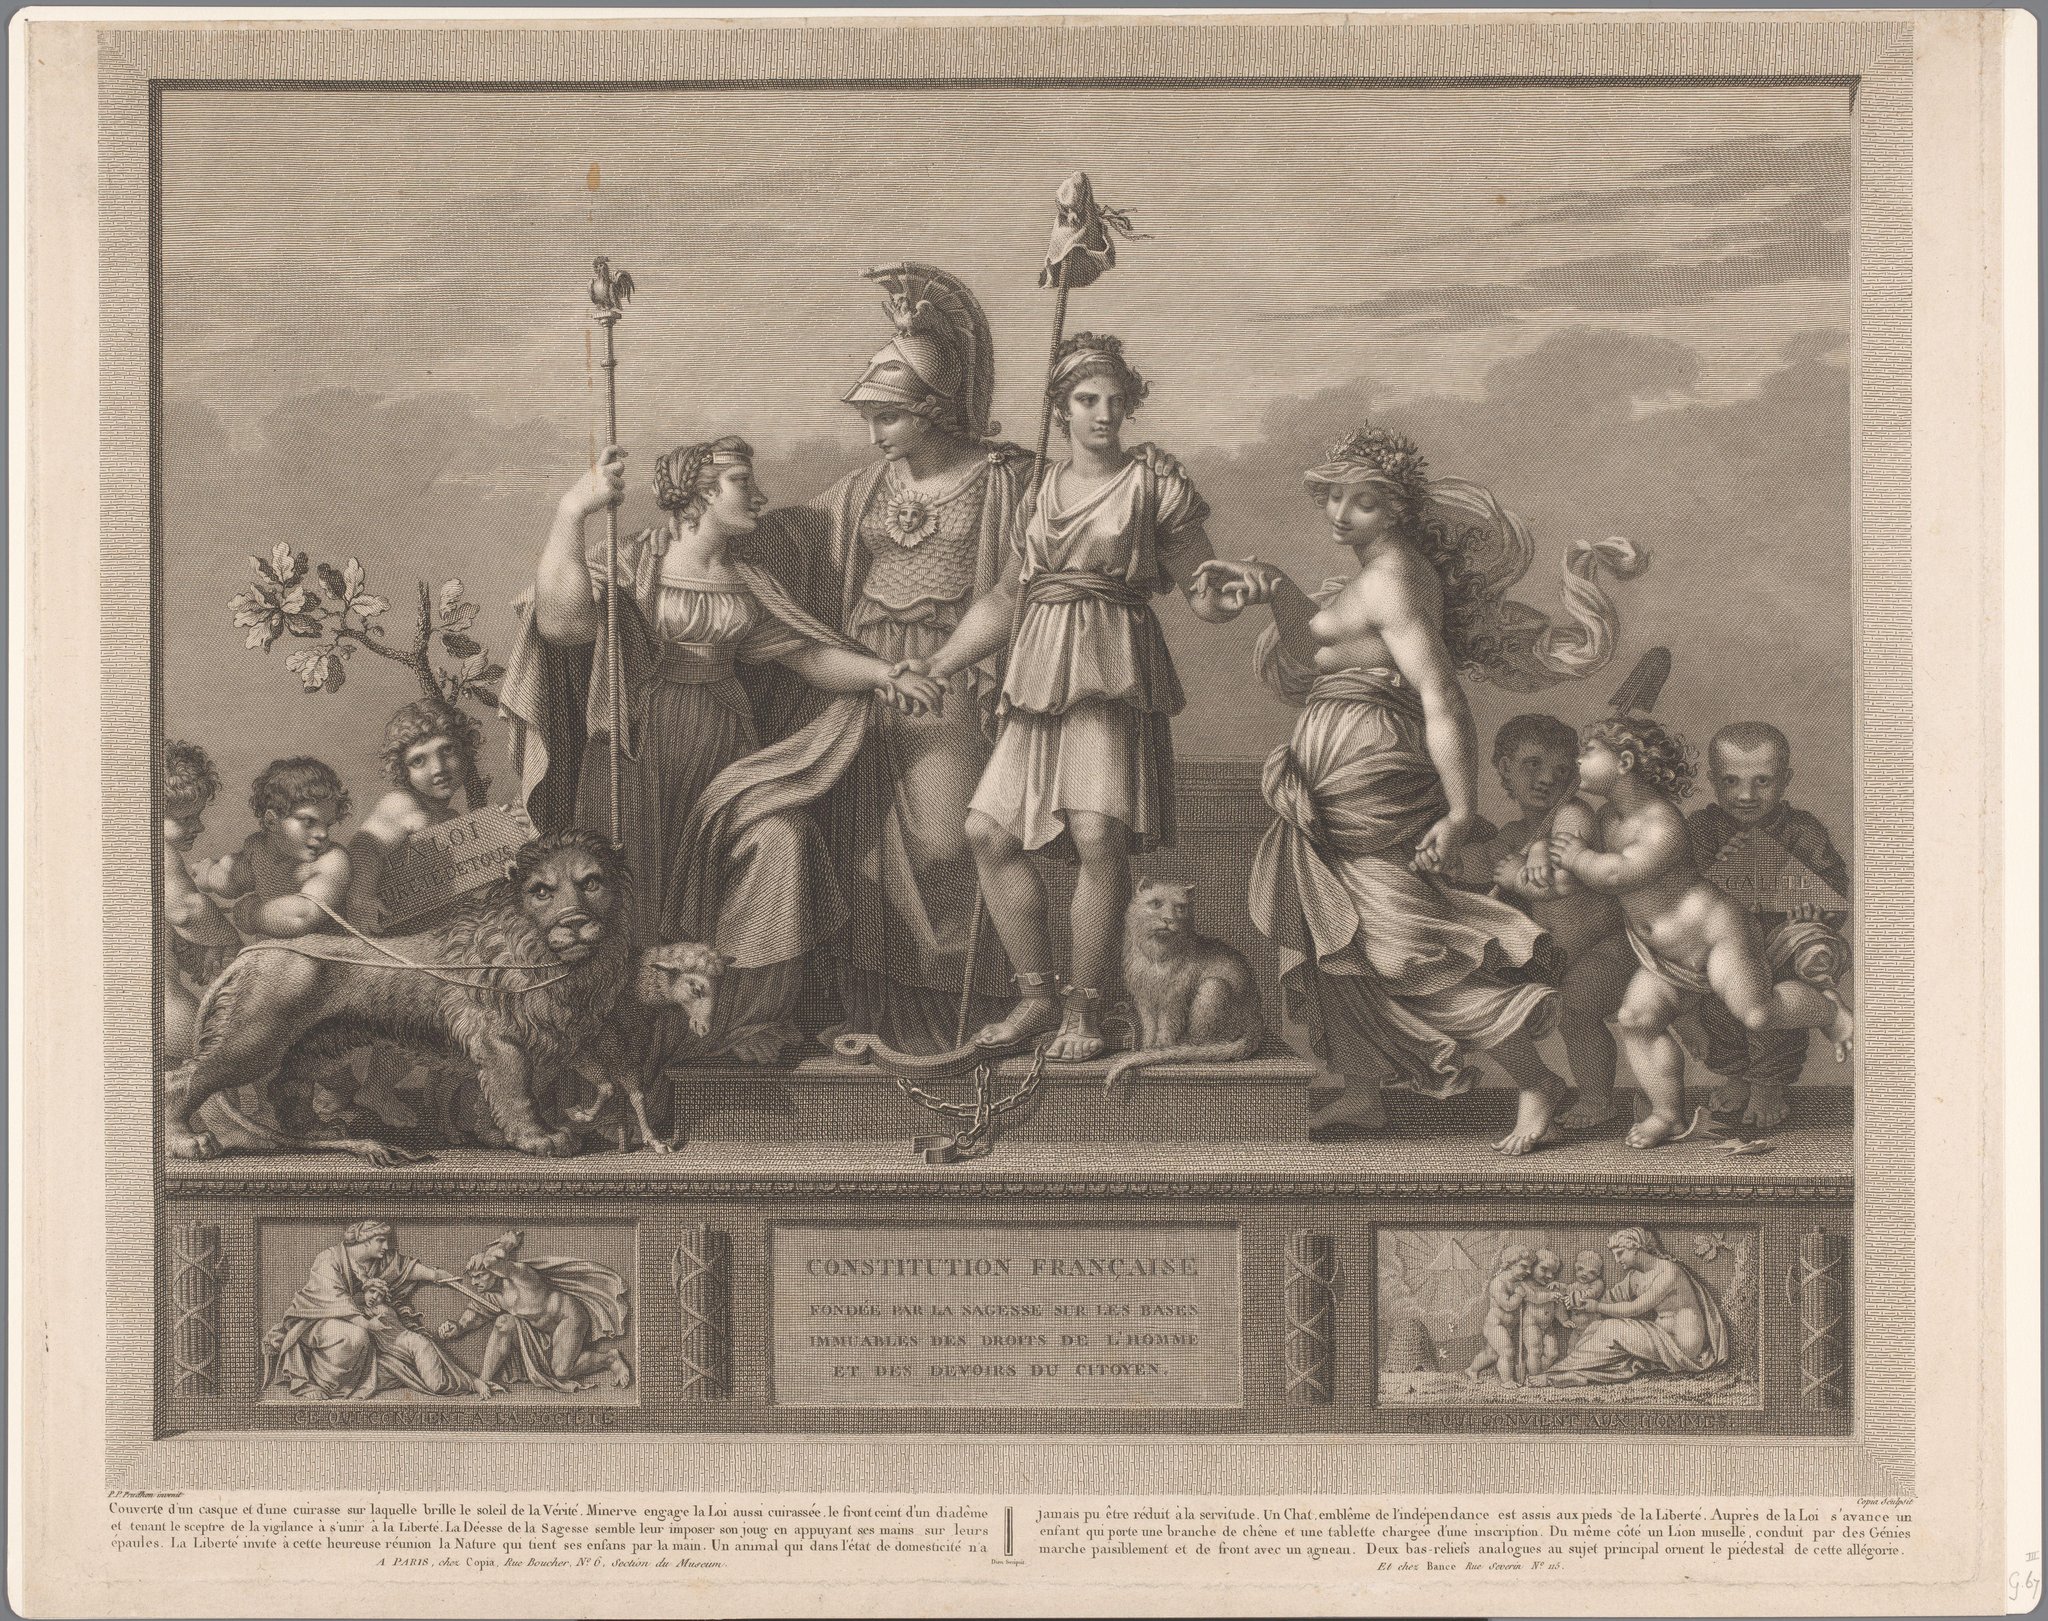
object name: print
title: Constitution Française/ fondée sur la sagesse, sur les bases (...)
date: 1792-1799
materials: paper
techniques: engraving, etching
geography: paris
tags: 'natura' (allegorical figure or scene; or as diana of ephesus, with many breasts); 'natura' (ripa), minerva as patroness, freedom, liberty; 'libertà' (ripa), equality, equity, fairness, righteousness; 'equalità', 'equità', 'giuditio giusto', 'ordine dritto e giusto', 'ugualità' (ripa)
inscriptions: collector's mark: Lugt 2228, collector's mark: Lugt 2760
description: Minerva laat Vrijheid en de Wet elkaar de hand reiken.